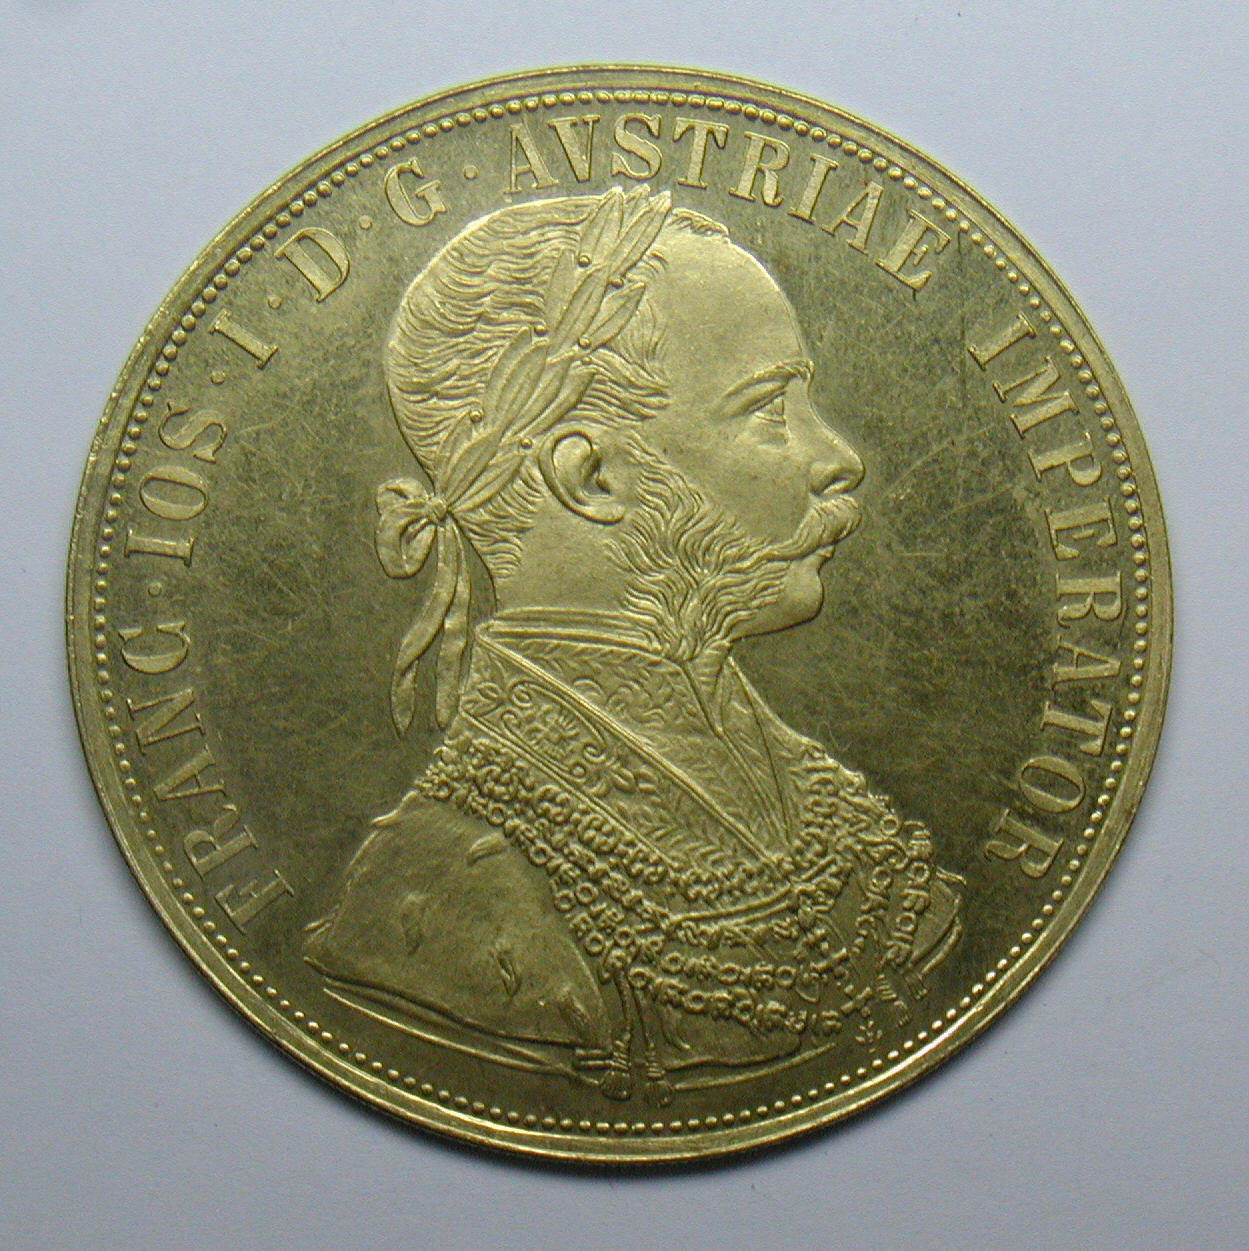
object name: ducat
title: Quad ducat of Francis Joseph I, Emperor of Austria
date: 1801-1900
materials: gold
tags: men,profiles,coat of arms